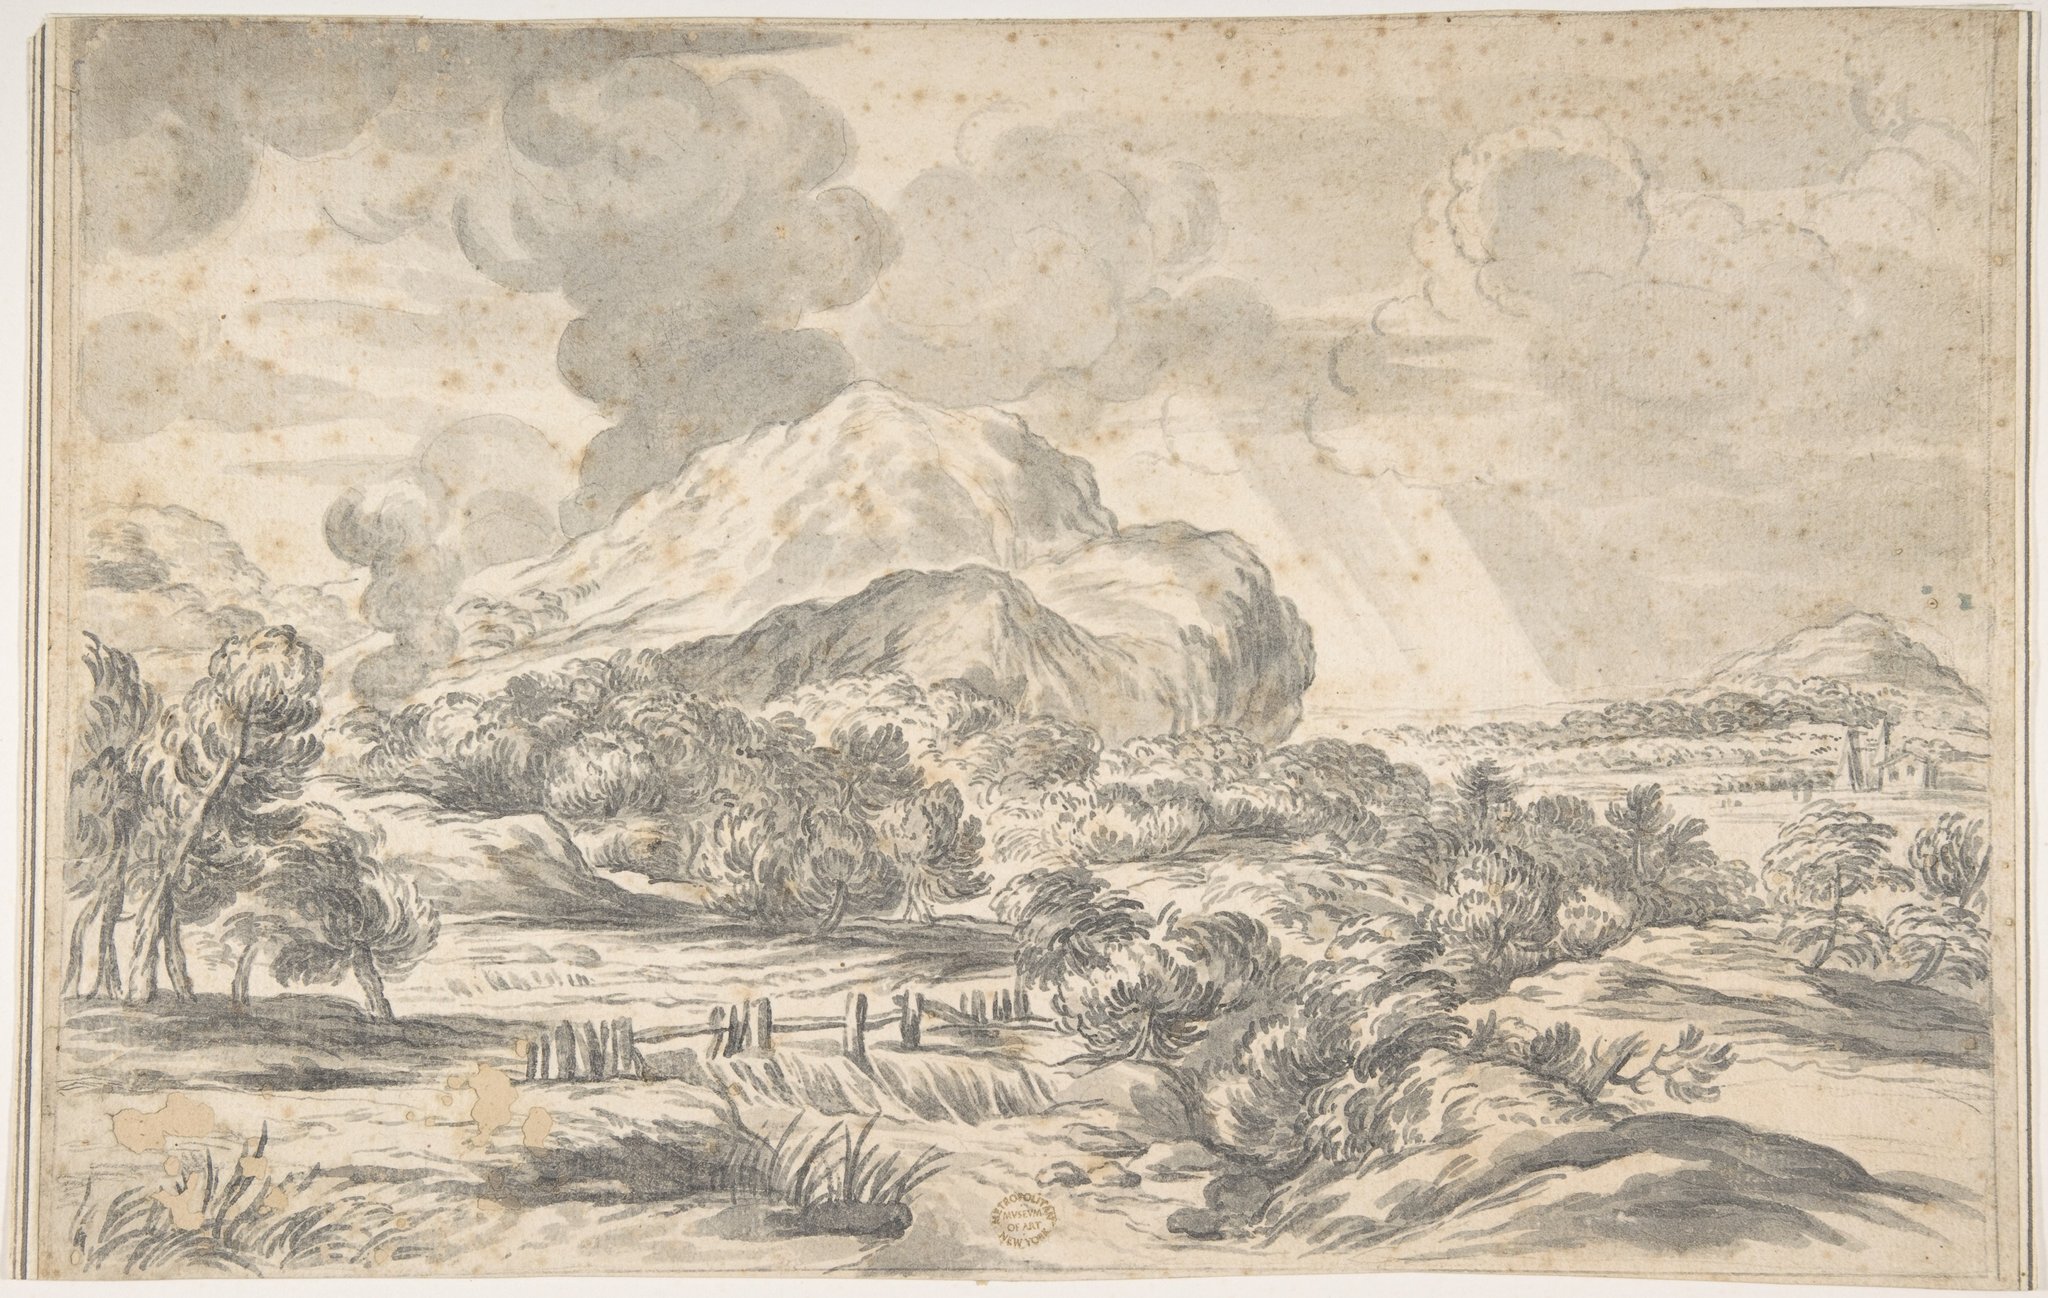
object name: drawing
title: Landscape with Mountains in the Distance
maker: ciro ferri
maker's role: artist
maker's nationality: italian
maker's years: 1634-1689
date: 1634-1689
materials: chalk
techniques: brush, wash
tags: mountains,landscapes,trees